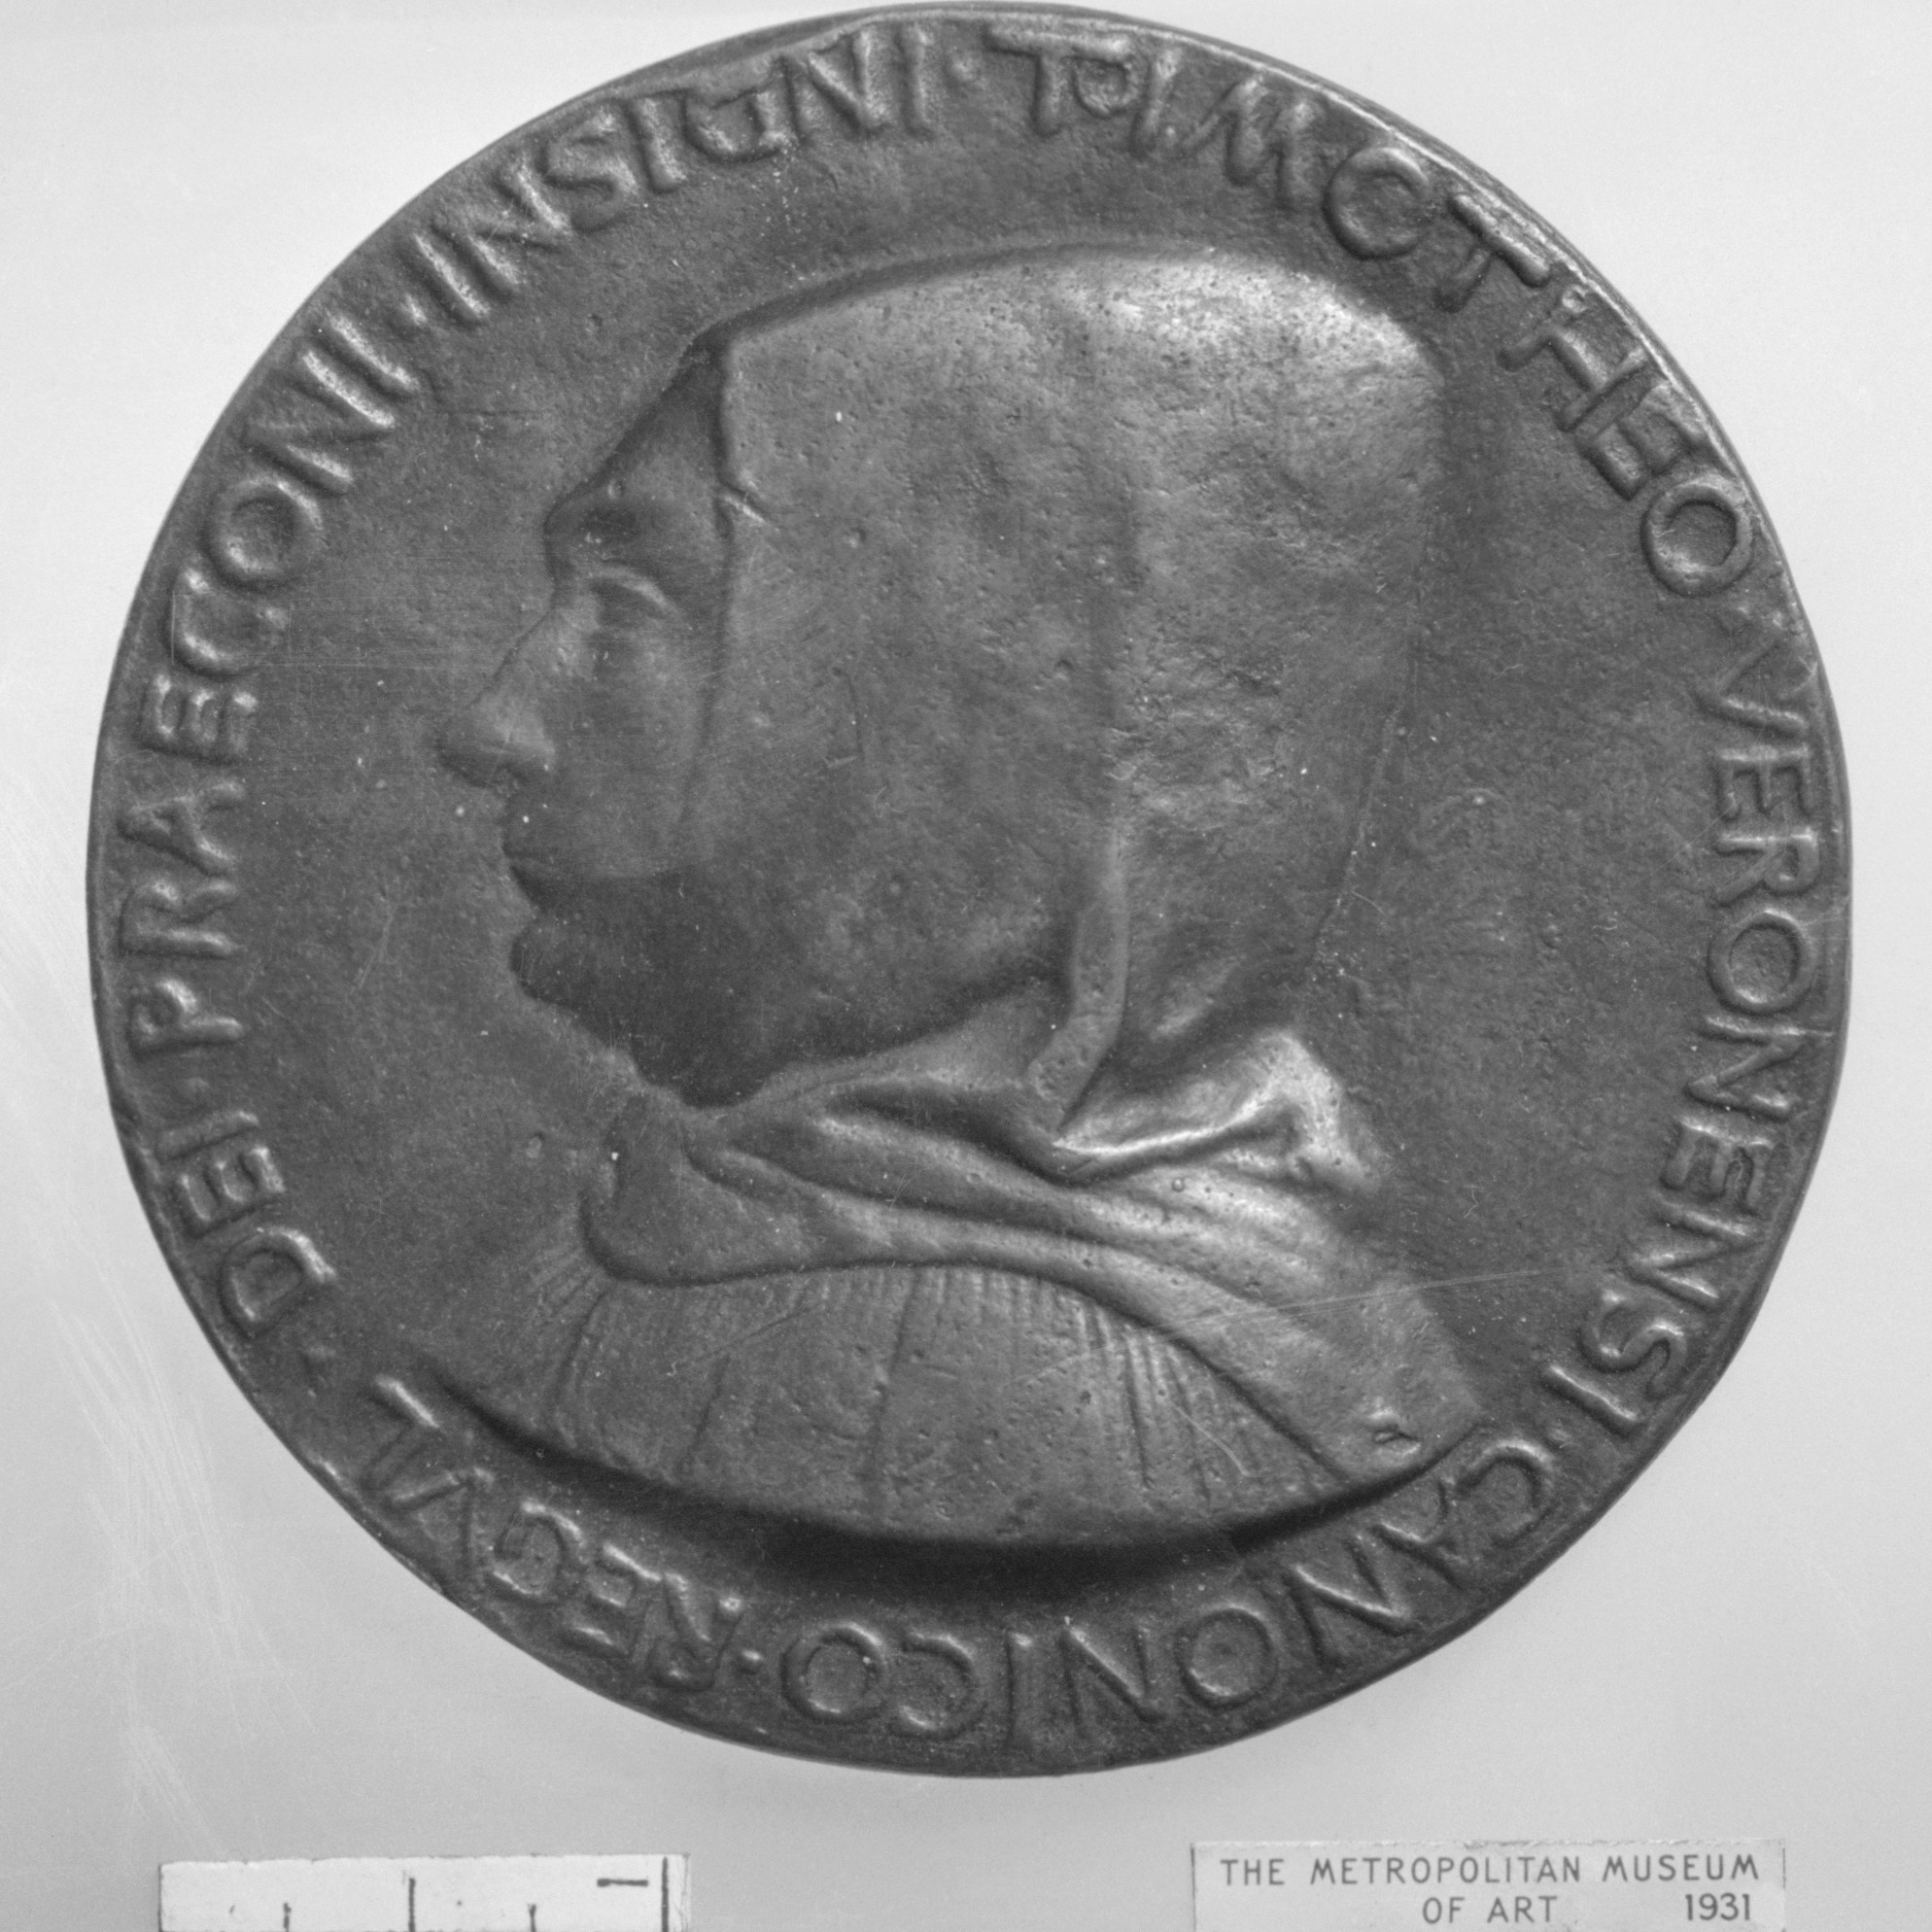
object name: medal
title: Maffei (Timoteo) Canon of Verona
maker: matteo de' pasti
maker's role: artist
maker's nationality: italian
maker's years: 1420-1467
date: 1501-1600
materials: bronze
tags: men,profiles